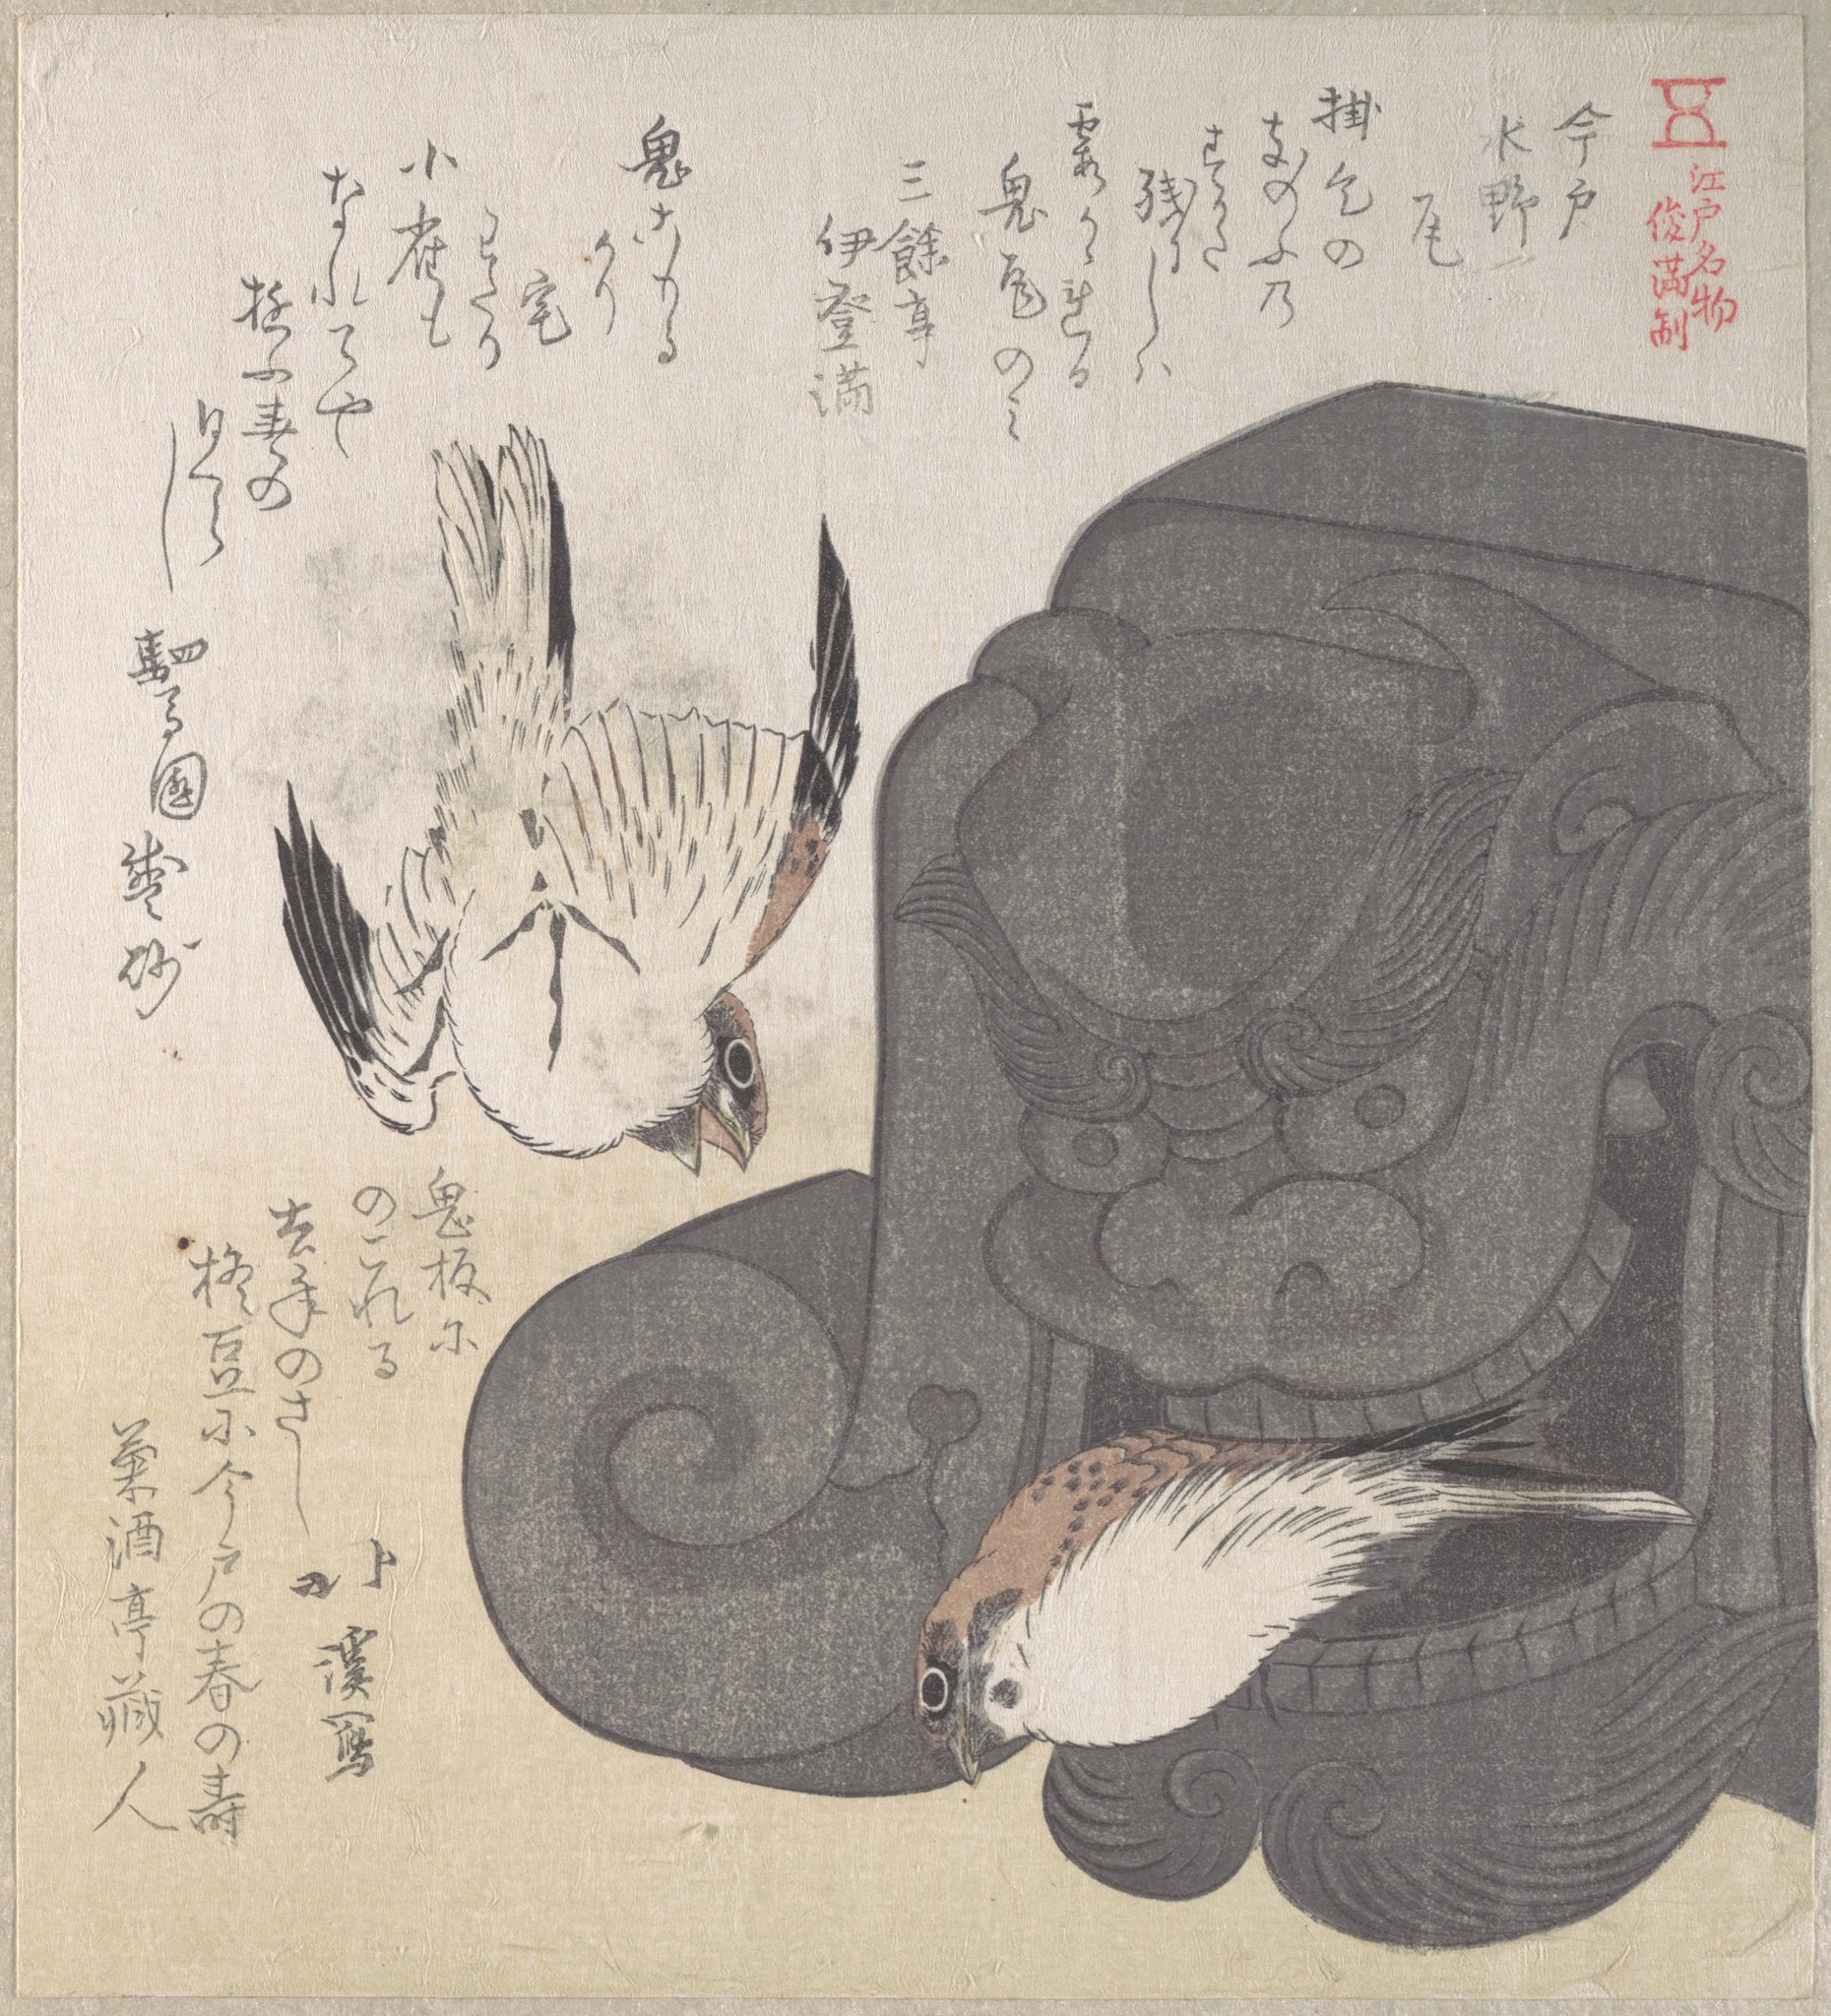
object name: print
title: Roof Tile and Sparrows; Specialities of Mizuno in Imado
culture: japanese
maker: totoya hokkei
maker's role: artist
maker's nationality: japanese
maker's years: 1780-1850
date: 1801-1900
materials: ink, paper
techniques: surimono, woodblock print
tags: birds